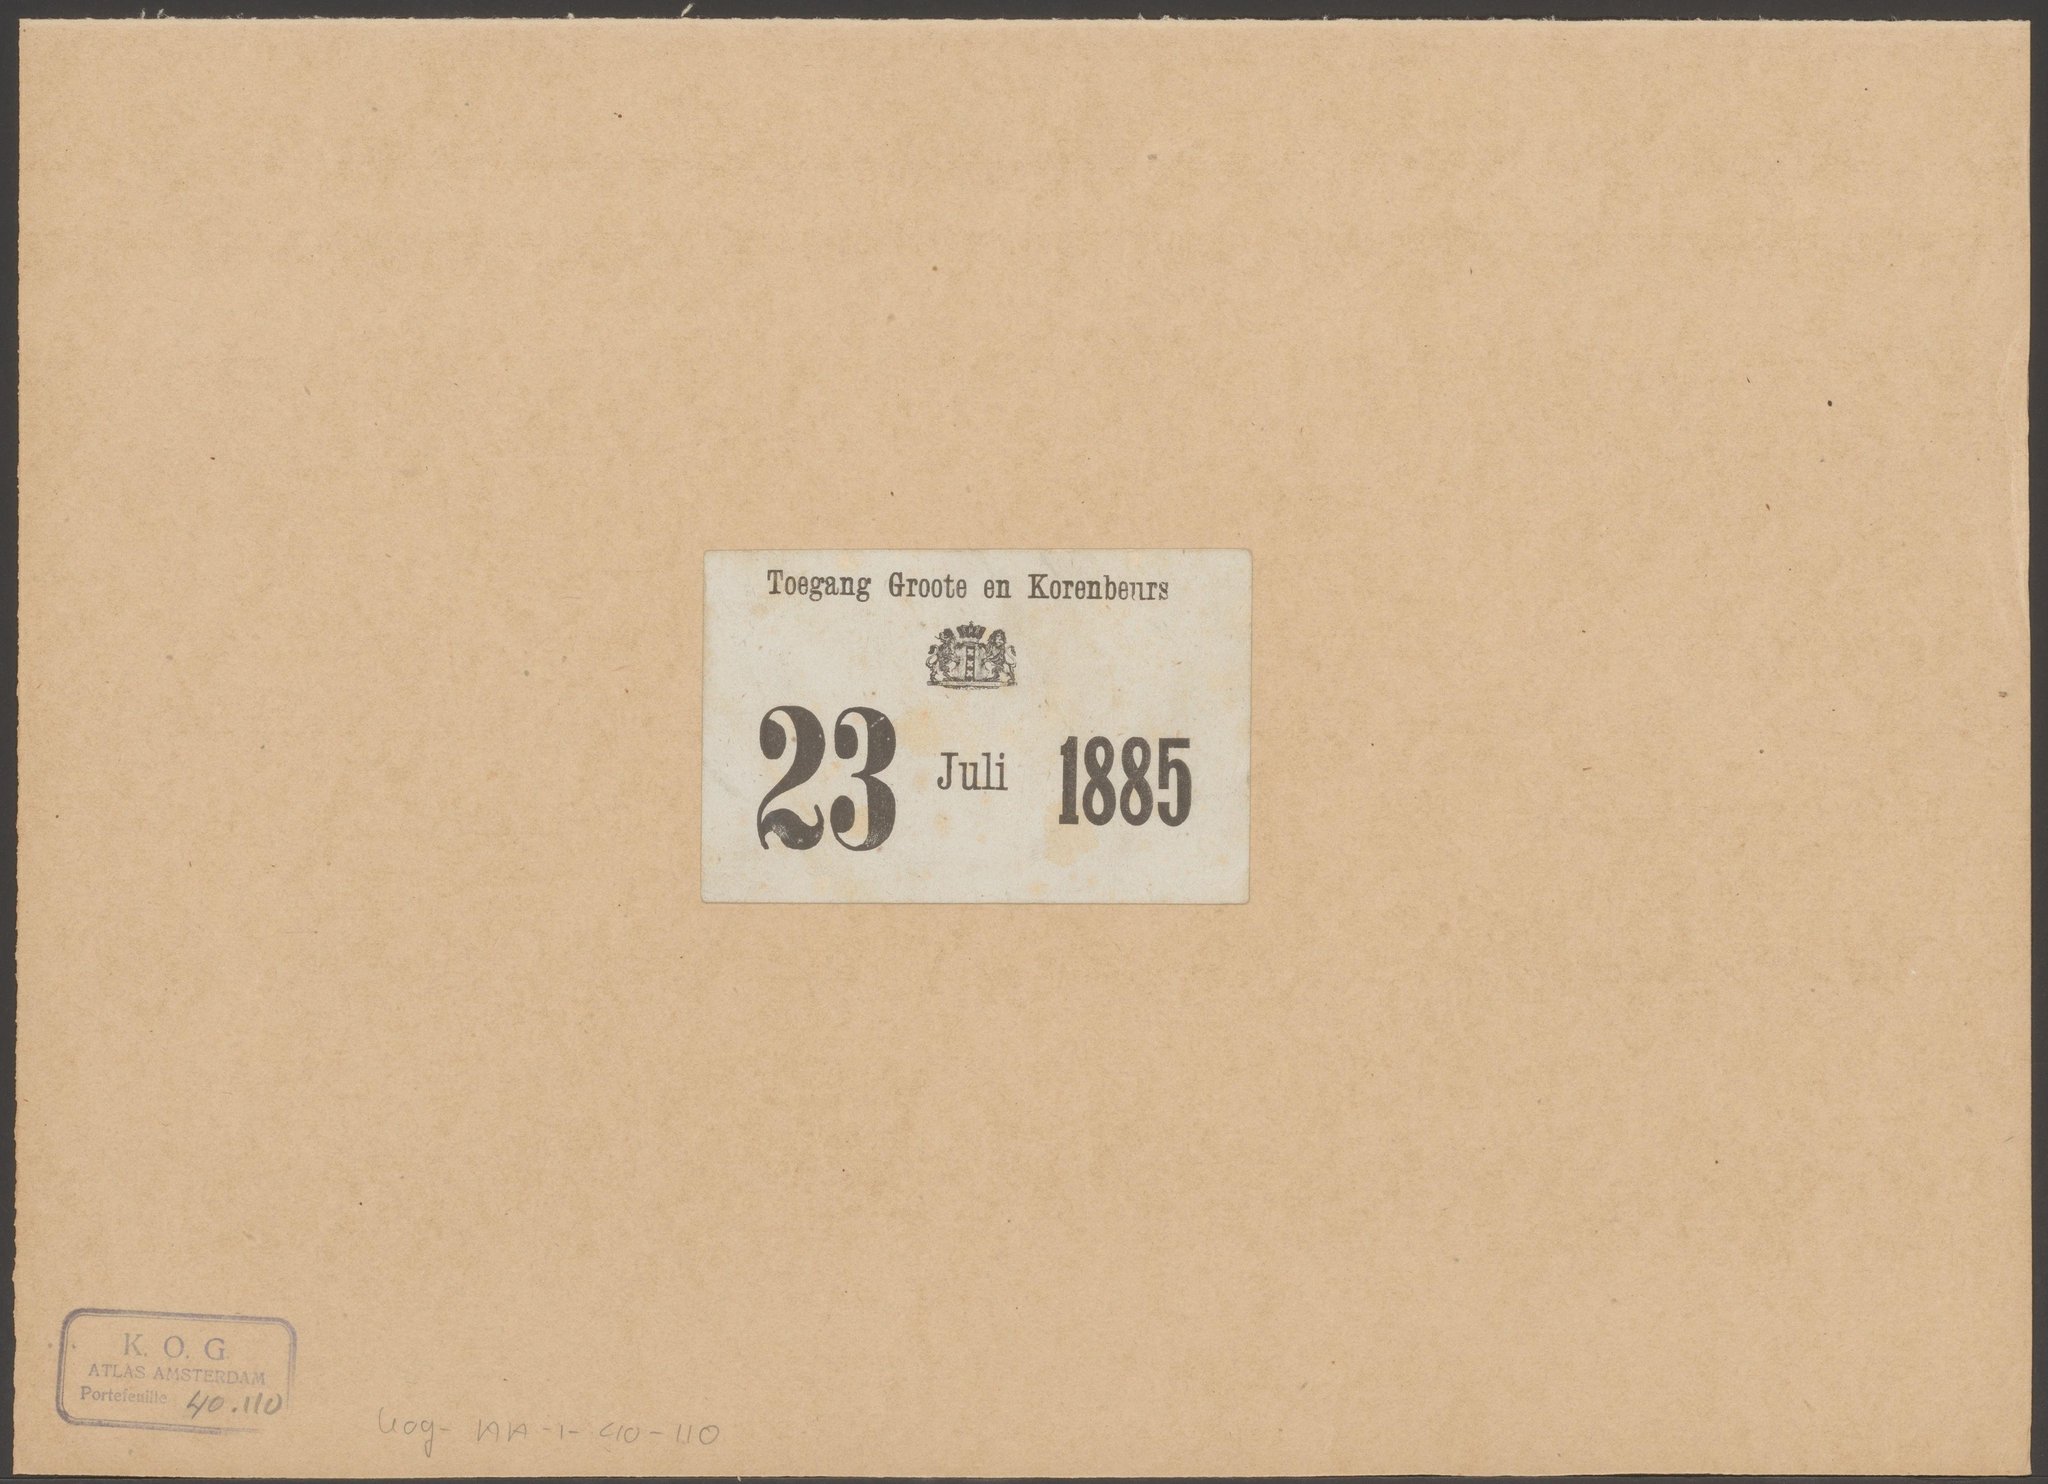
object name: admission ticket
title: Toegangsbewijs voor de Beurs van Zocher en de Korenbeurs te Amsterdam op 23 juli 1885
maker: Anonymous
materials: paper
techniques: letterpress printing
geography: netherlands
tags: coat of arms (as symbol of the state, etc.) (+ city; municipal), stock exchange, stock-market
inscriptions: collector's mark: Lugt 1641b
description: Onderwerpsrubriek binnen de Atlas Amsterdam: Handel en Zeevaart: Hulpbeurs op de Dam en Beurs (Dam).